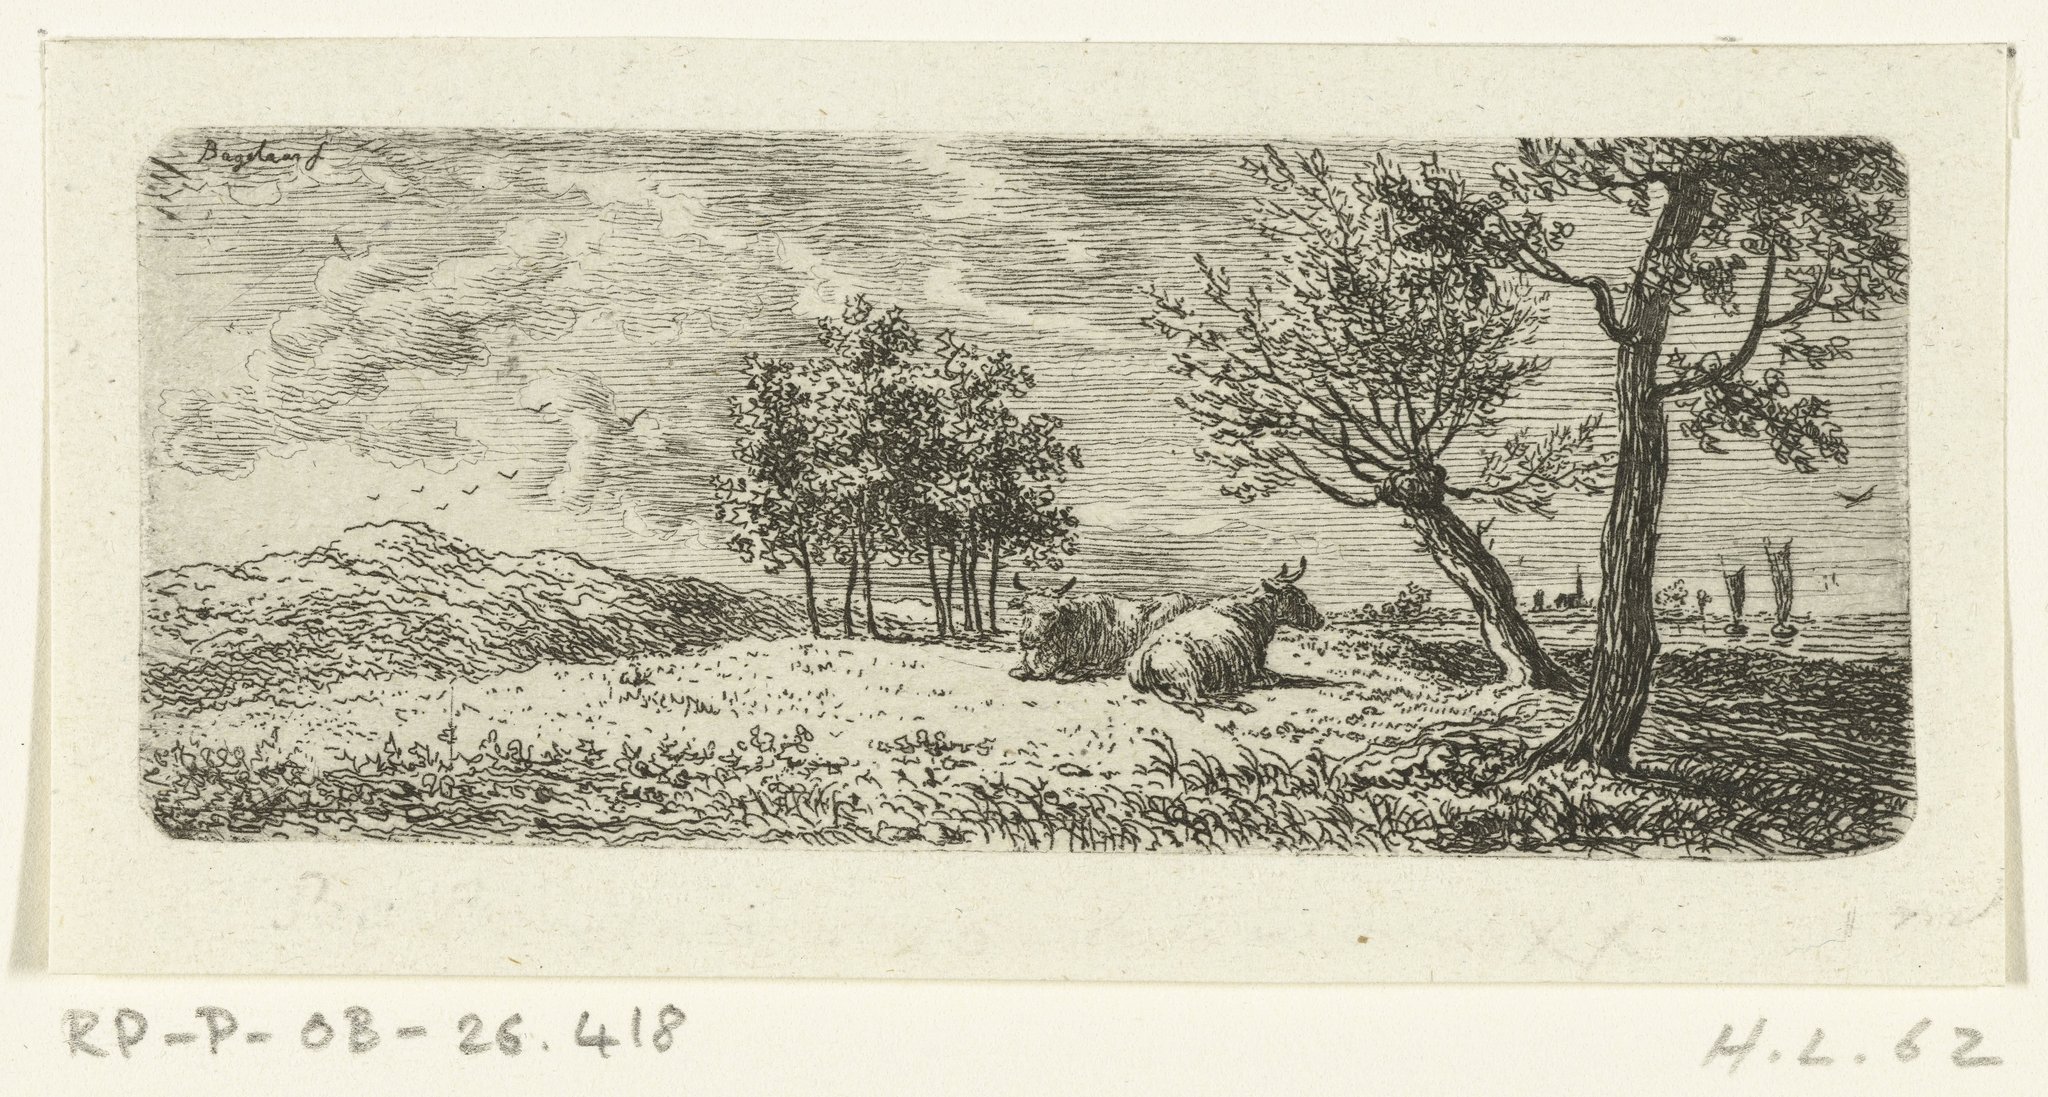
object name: print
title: Landschap met twee liggende koeien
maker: ernst willem jan bagelaar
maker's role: draughtsman, print maker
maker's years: 1775-1837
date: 1798-1837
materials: paper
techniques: drypoint, etching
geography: netherlands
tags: cow, landscapes in the temperate zone